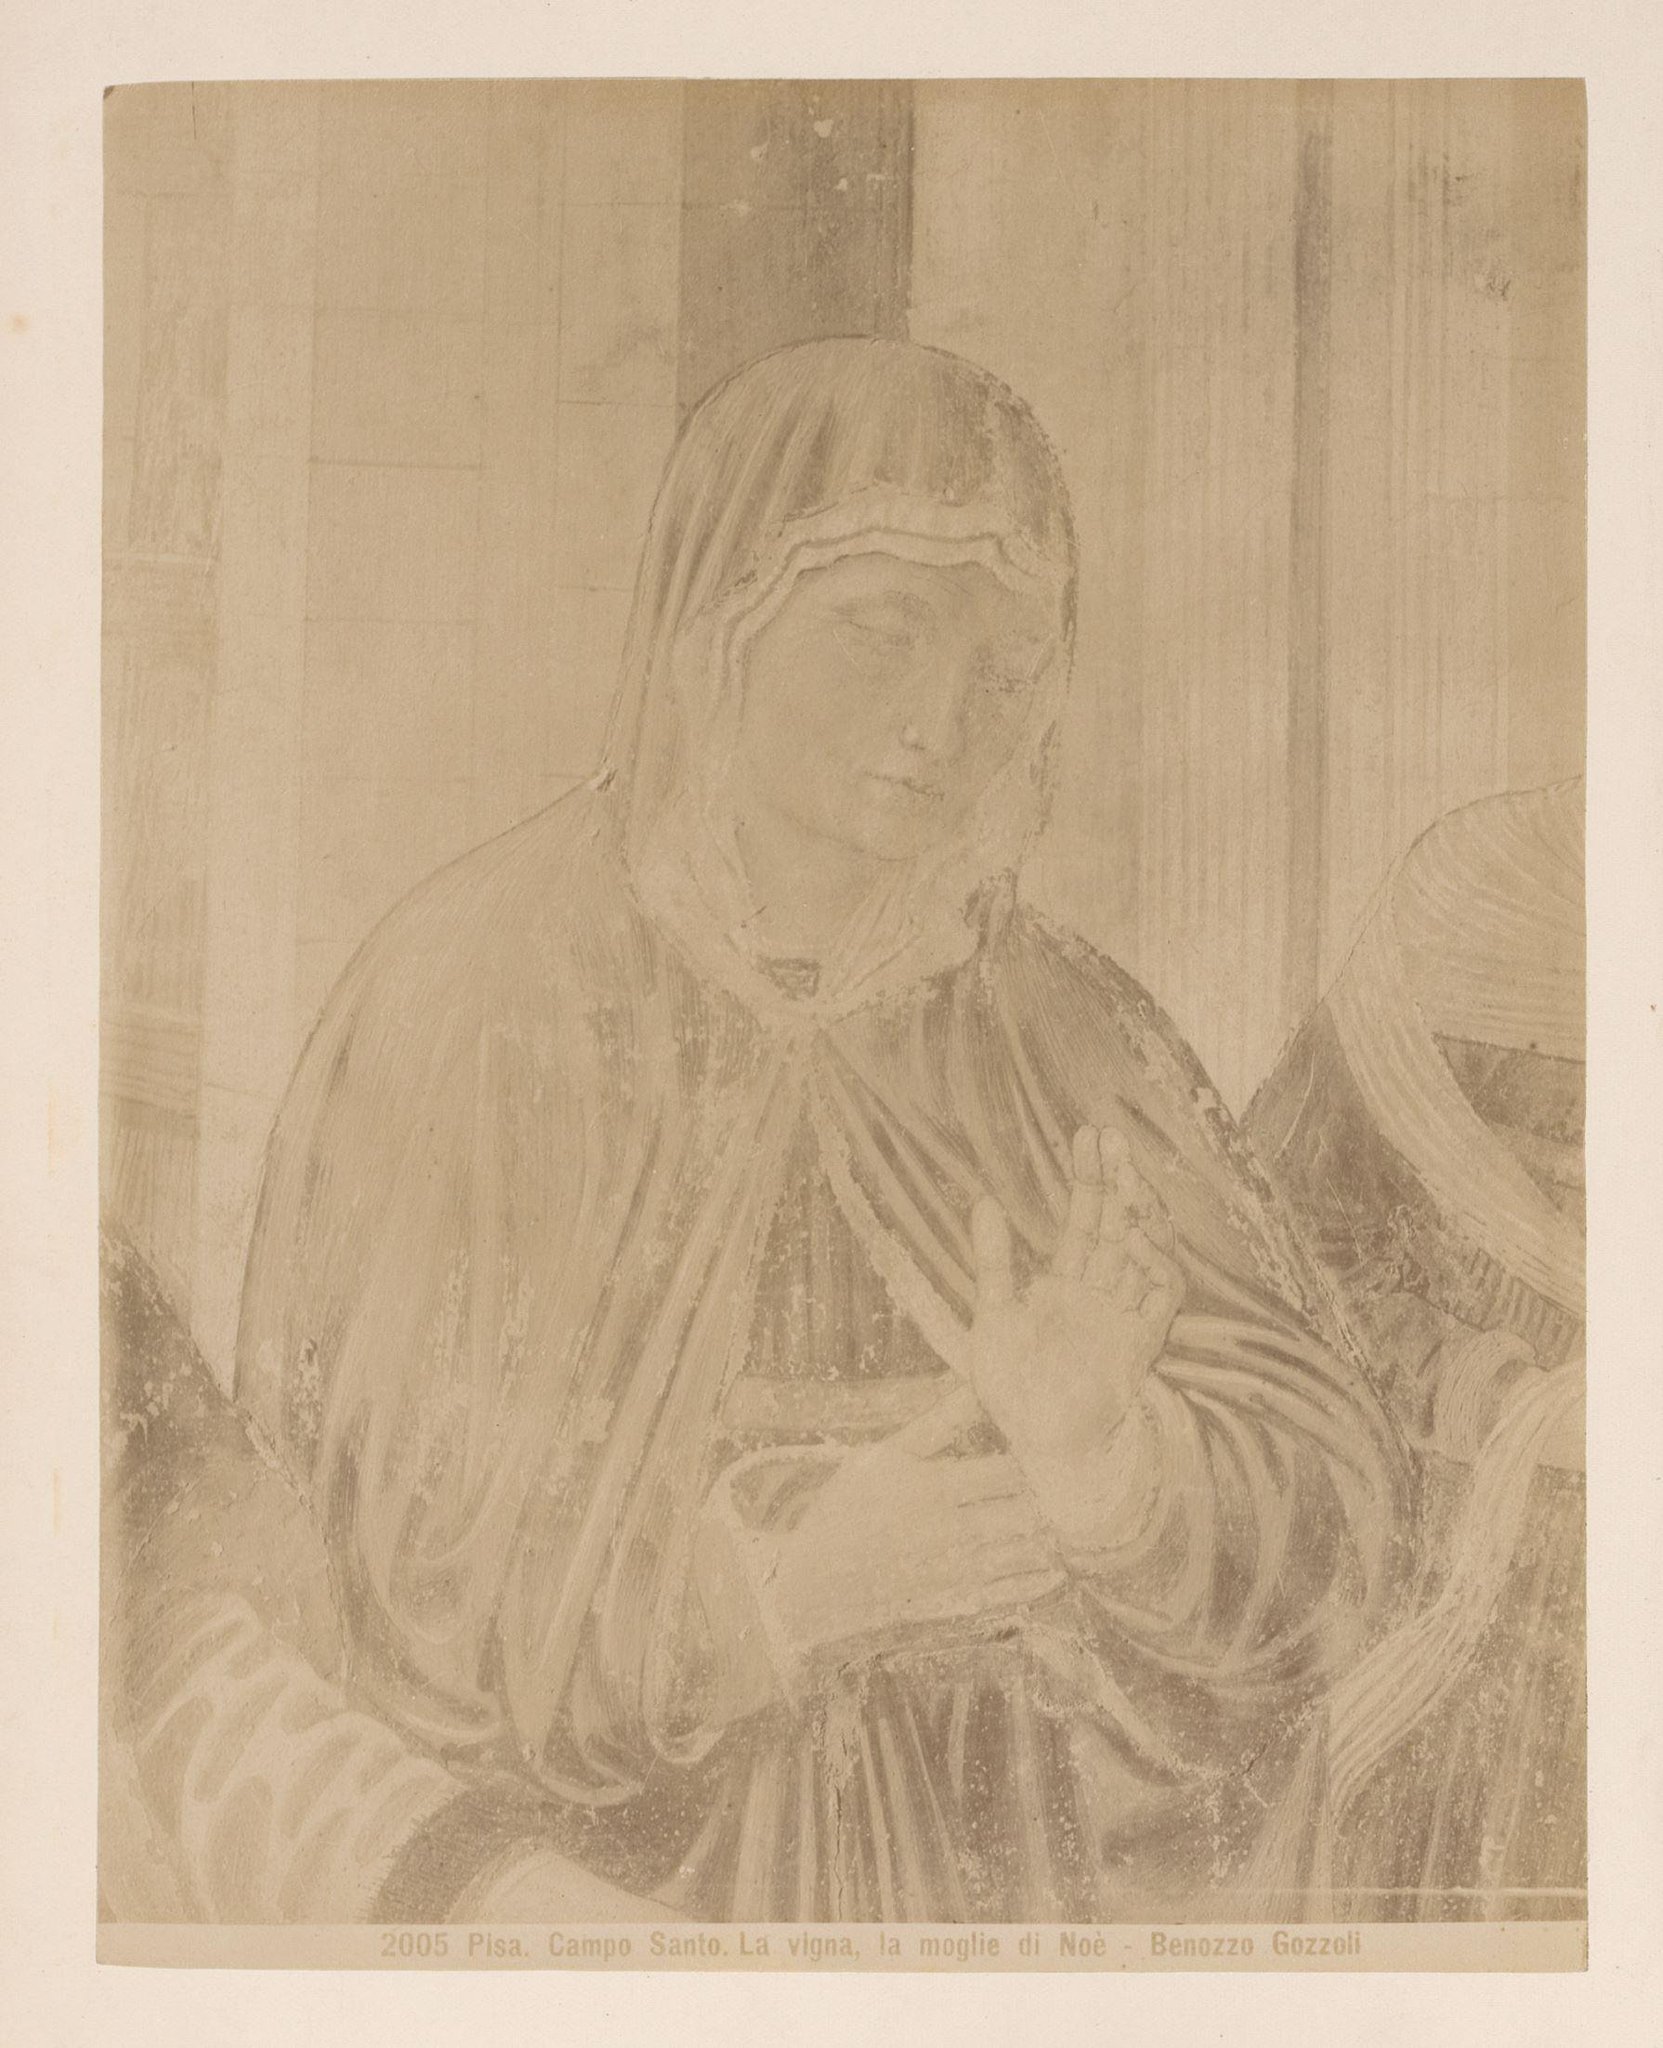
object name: reproduction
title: Fotoreproductie van het fresco De vrouw van Noach door Benozzo Gozzoli in het Camposanto te Pisa, Italië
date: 1860-1881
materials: paper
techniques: albumen print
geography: pisa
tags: picture, painting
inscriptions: number: ‘2005’